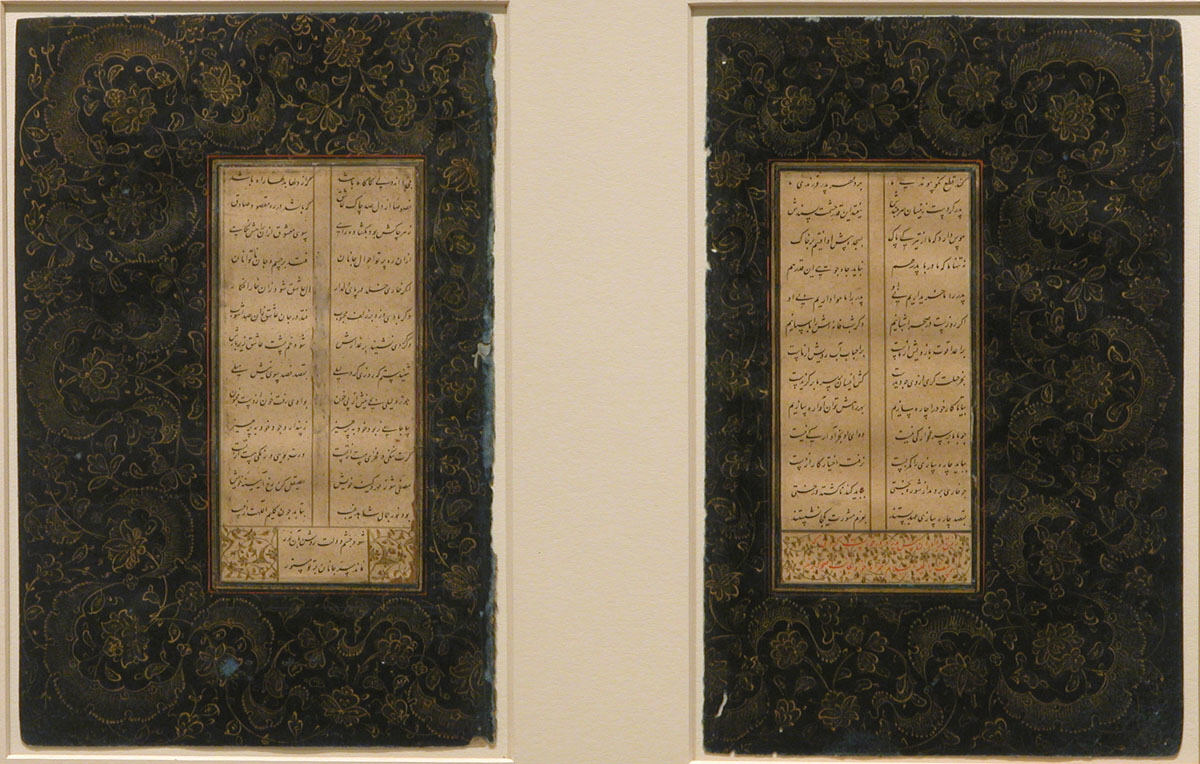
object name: folio from an illustrated manuscript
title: Folio from a Yusuf and Zulaykha Manuscript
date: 1501-1700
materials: gold, ink, paper, watercolor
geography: iran